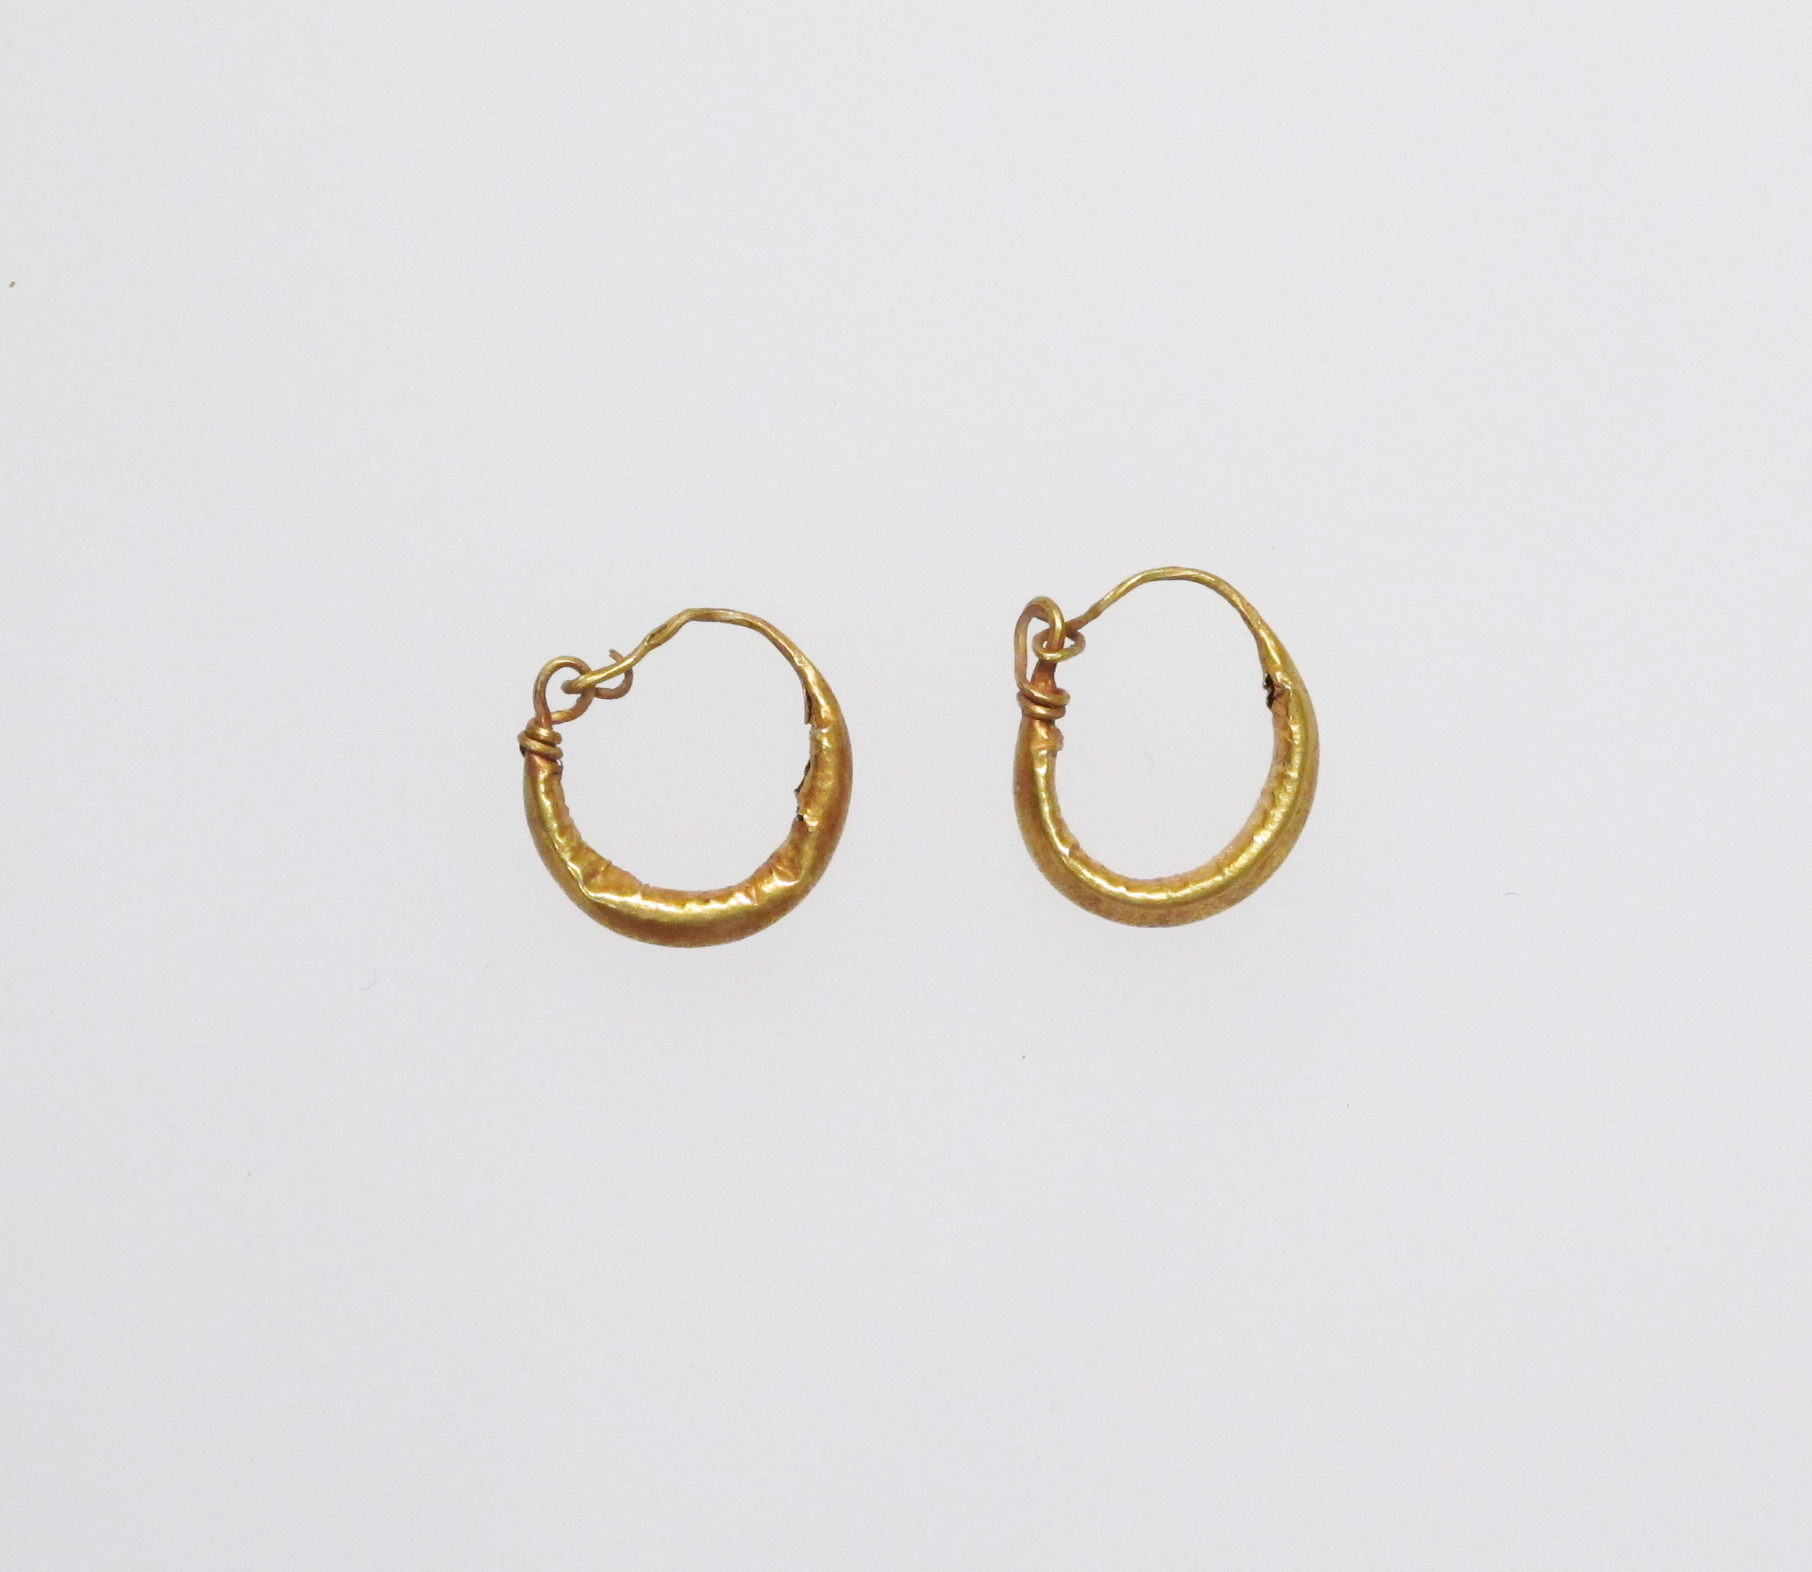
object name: earring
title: Earrings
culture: roman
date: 101-300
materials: gold